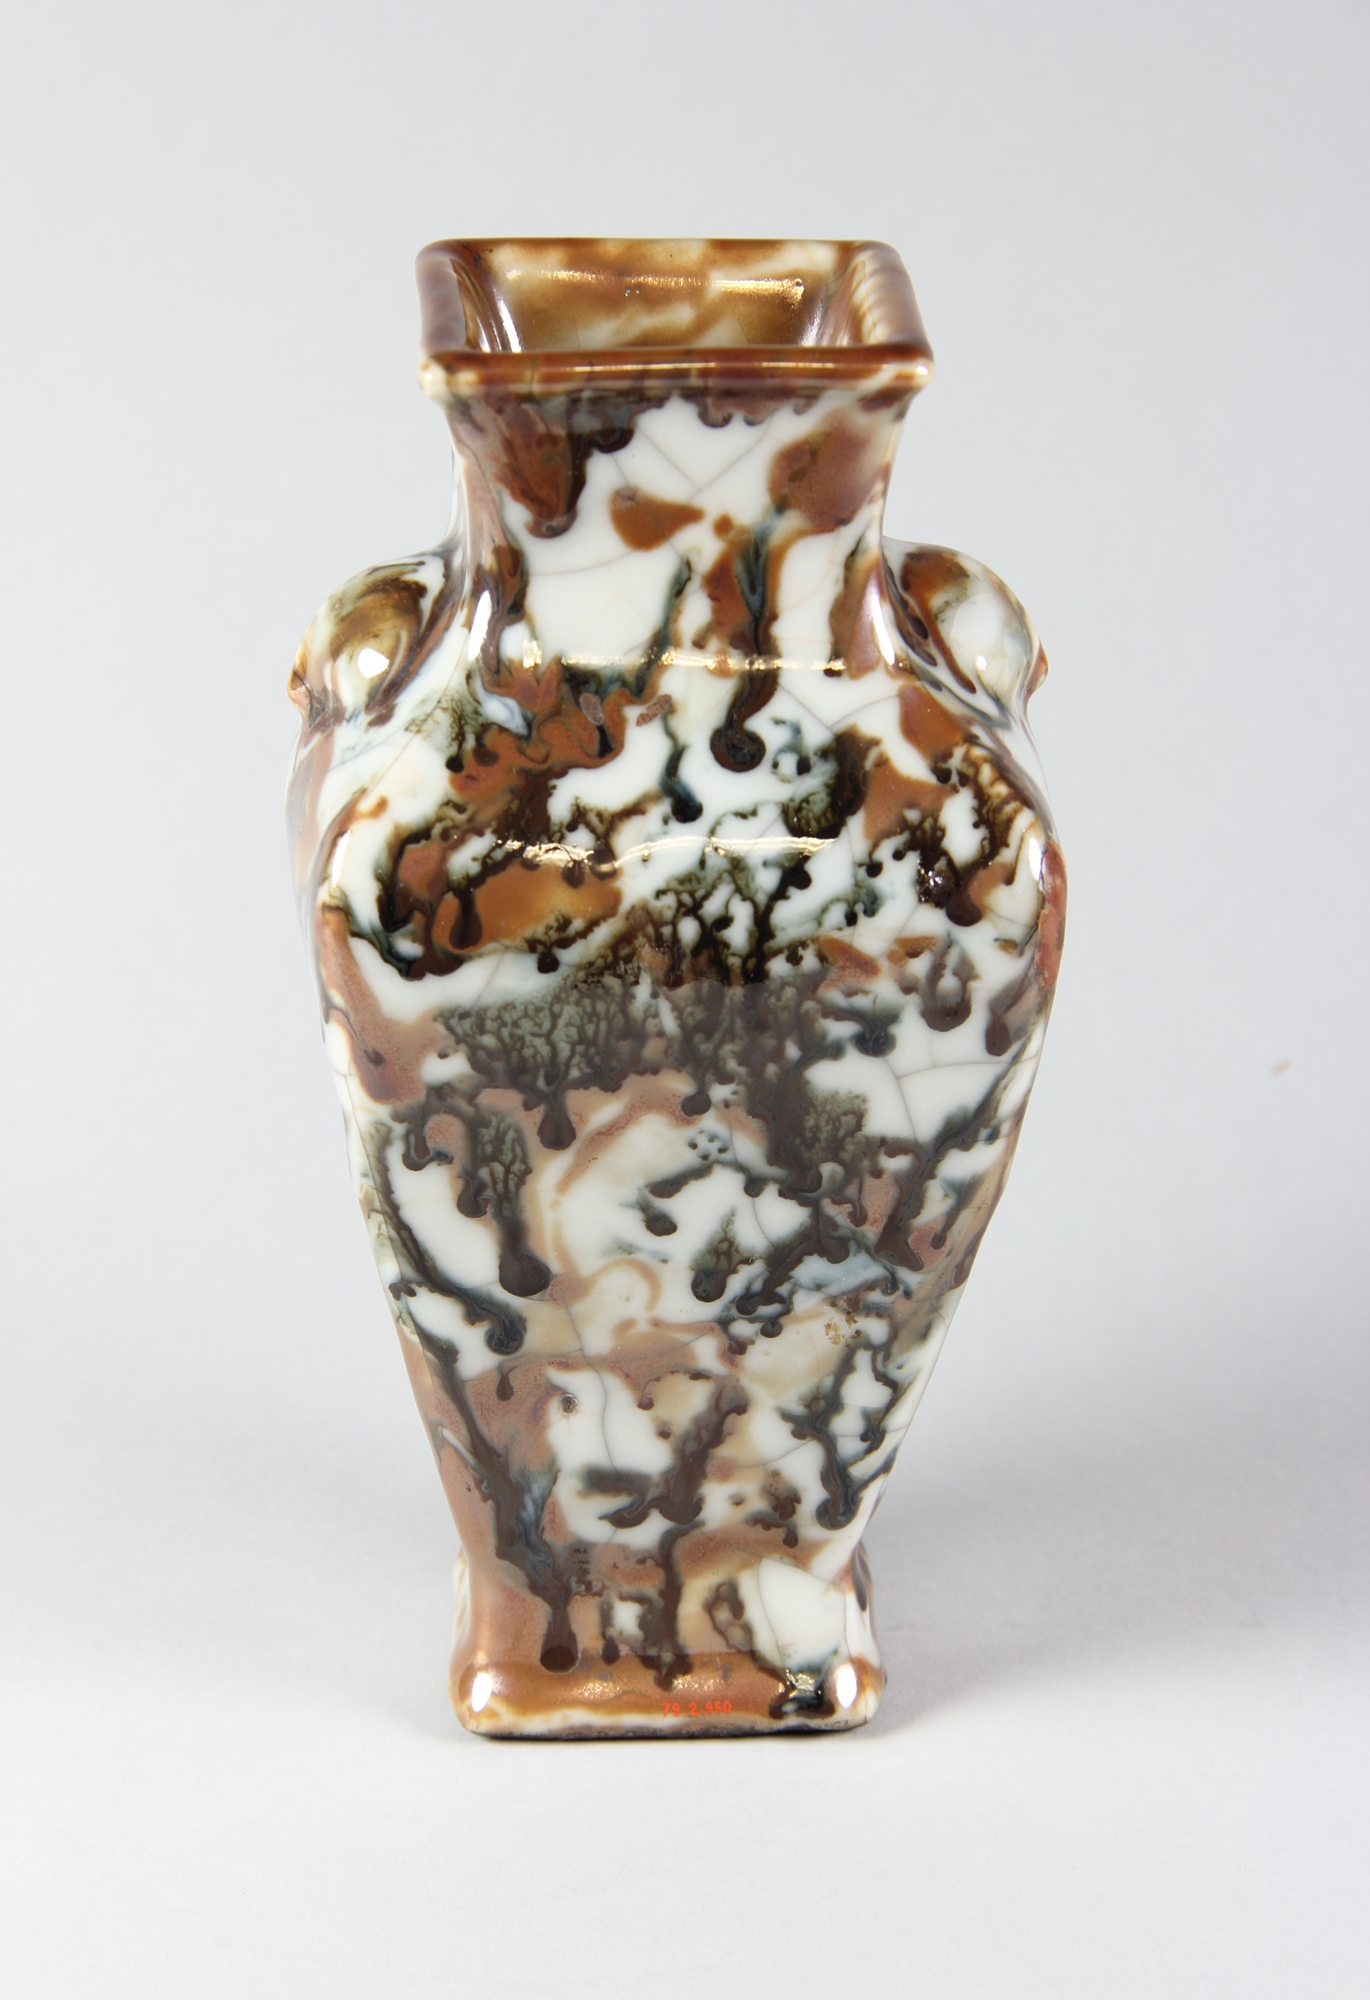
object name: vase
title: Rectangular vase with animal masks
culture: chinese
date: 1801-1900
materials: glaze, marble, porcelain